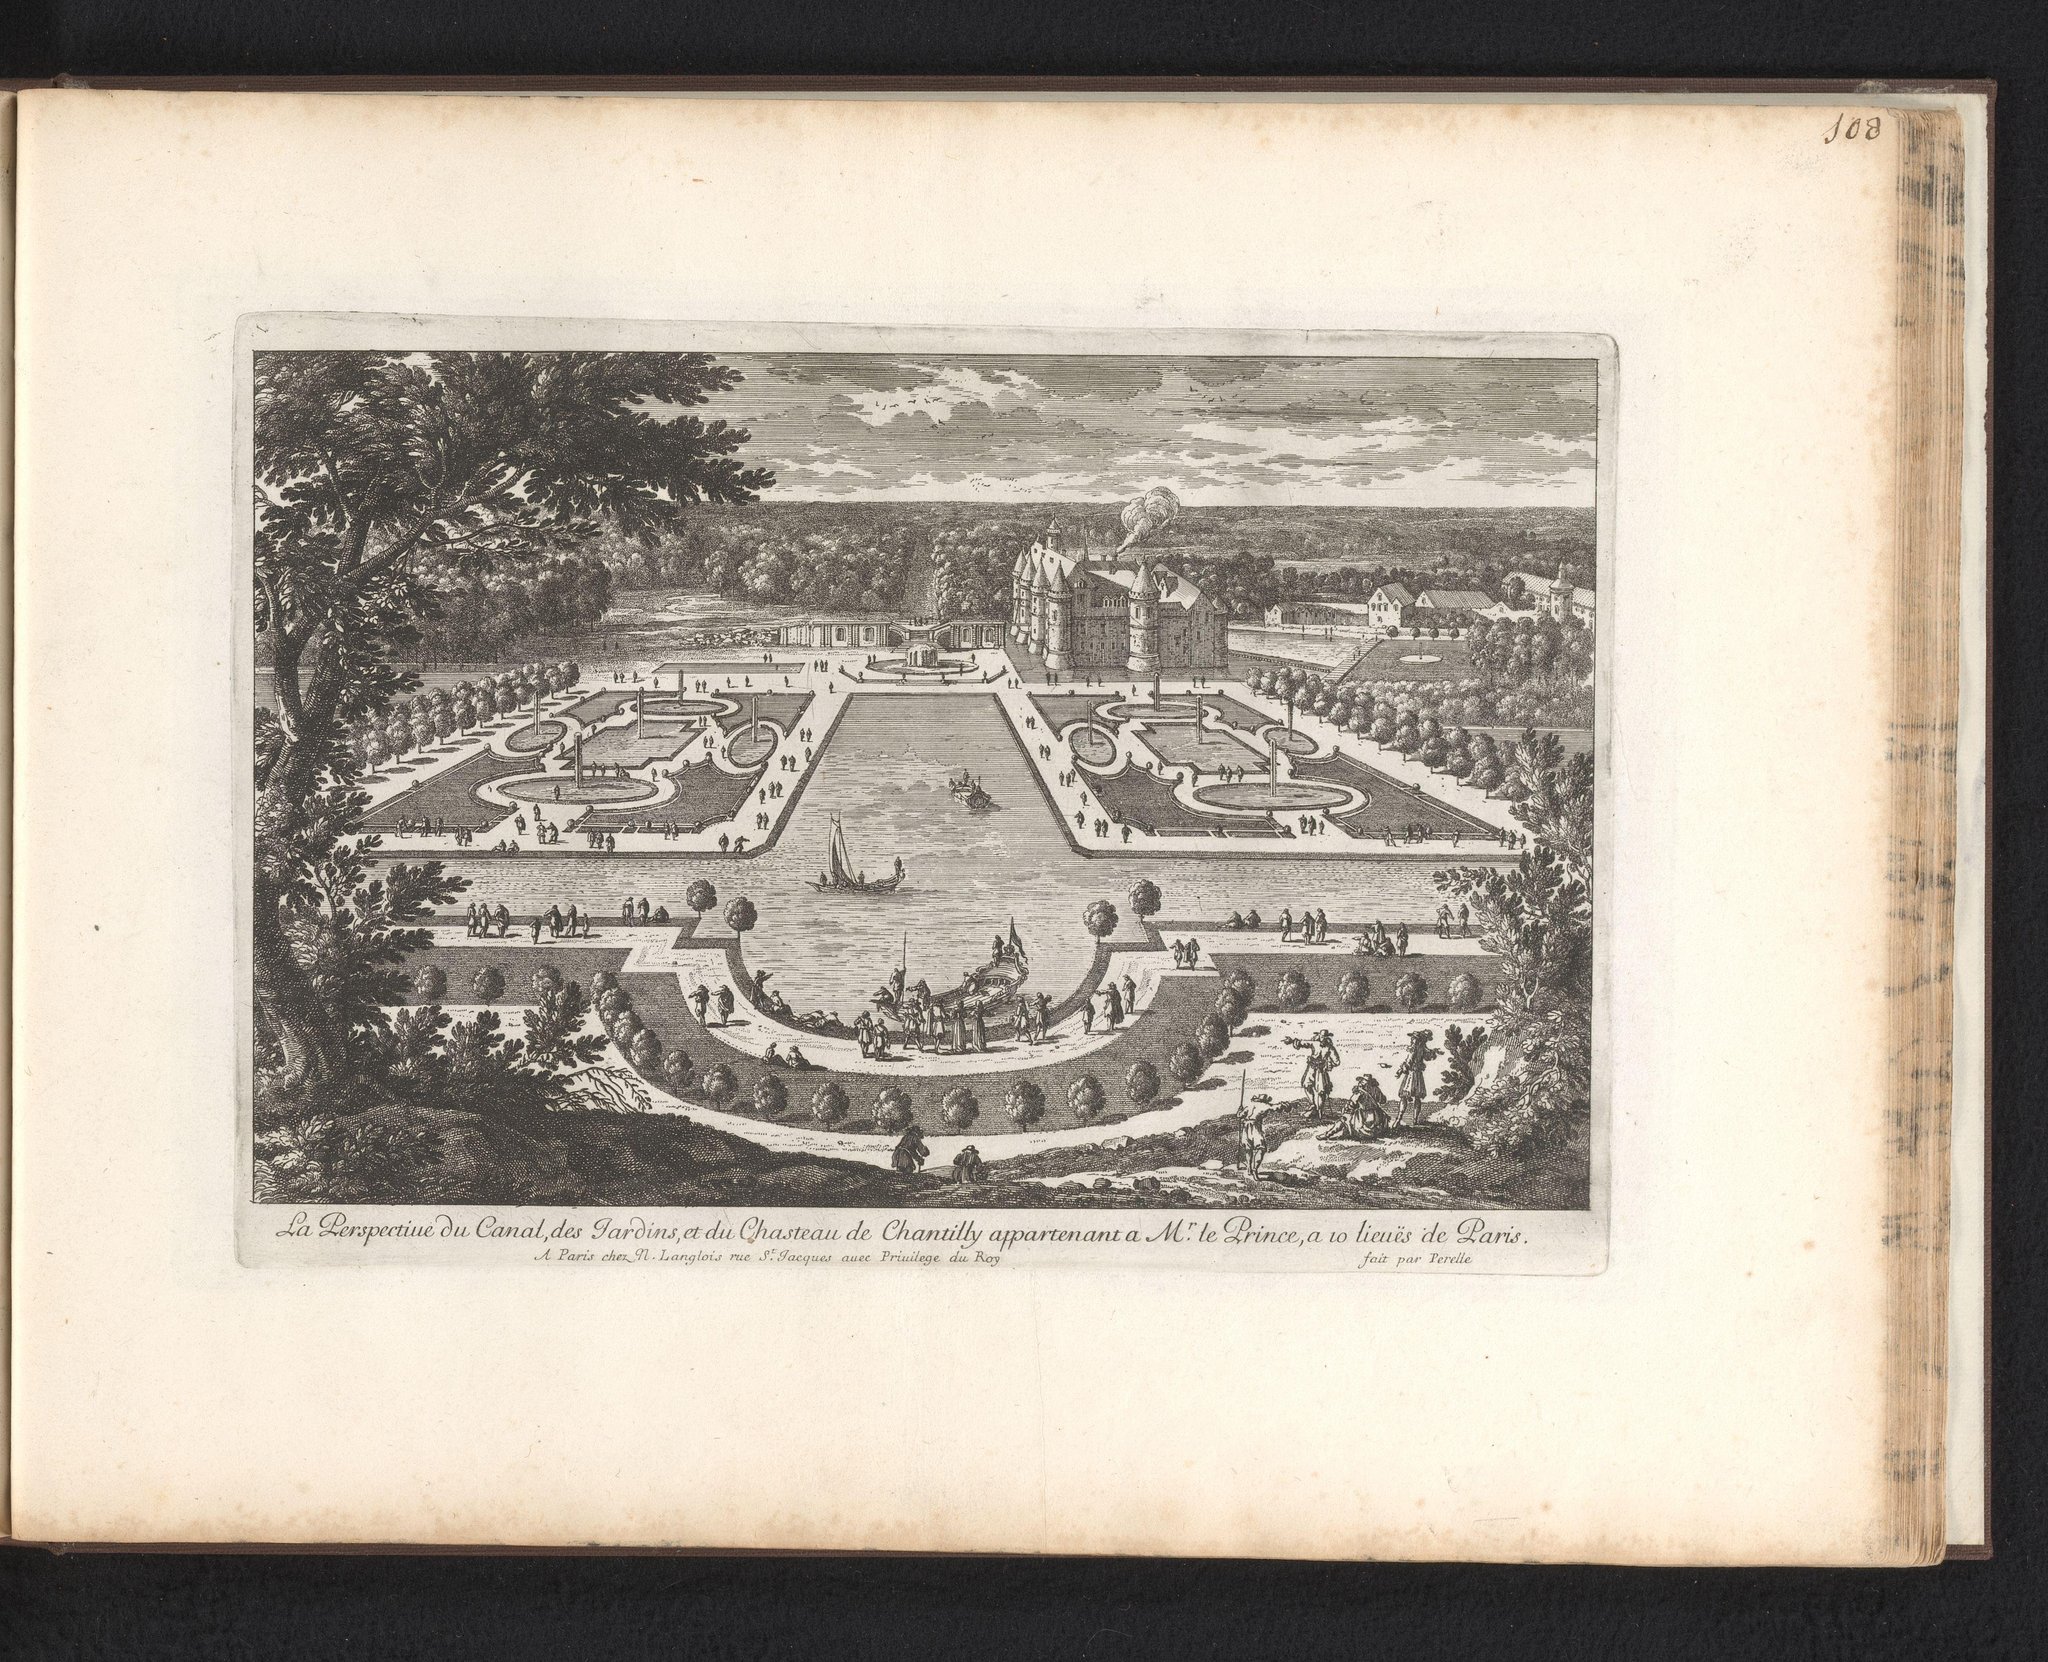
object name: print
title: La Perspective du Canal des Jardins et du Chasteau de Chantilly (...)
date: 1650-1695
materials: paper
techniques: etching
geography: paris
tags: french or architectonic garden; formal garden, landscape with tower or castle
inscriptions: collector's mark: Lugt 2228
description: Prenten met het signatuur 'Perelle' kunnen zowel door vader Gabriel als door zonen Nicolas en Adam gemaakt zijn. De uitgevers vader en zoon Nicolas Langlois worden allebei vermeld als N. Langlois op hetzelfde adres.